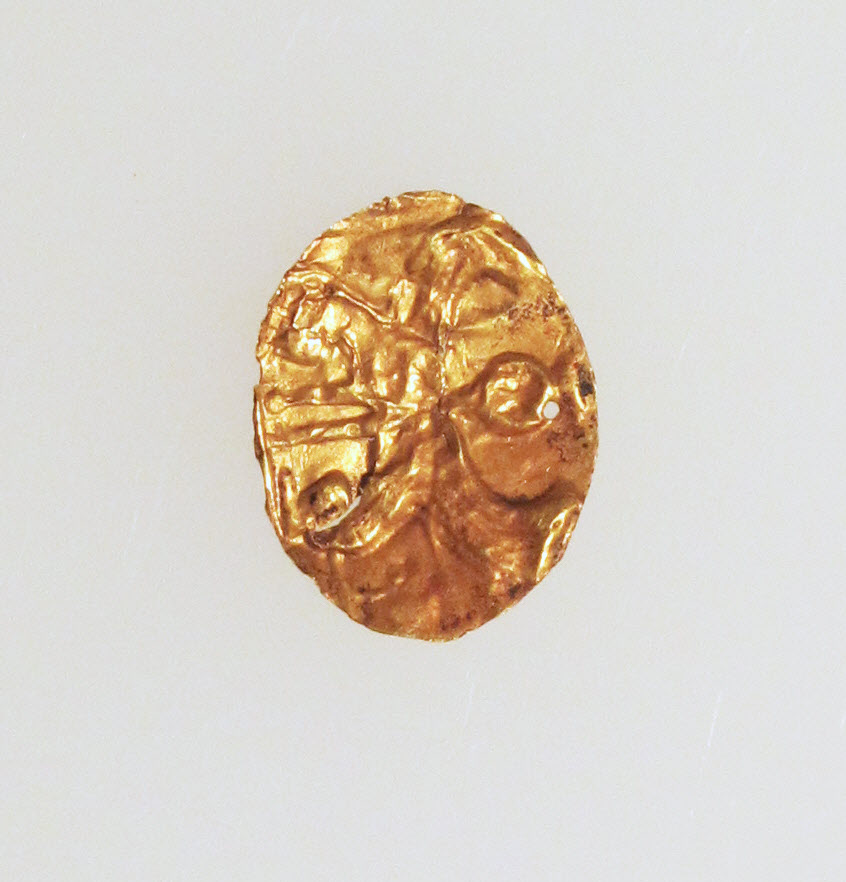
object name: roundel, disk with coin impression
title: Roundel, disk with coin impressions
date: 400-301 BCE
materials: gold